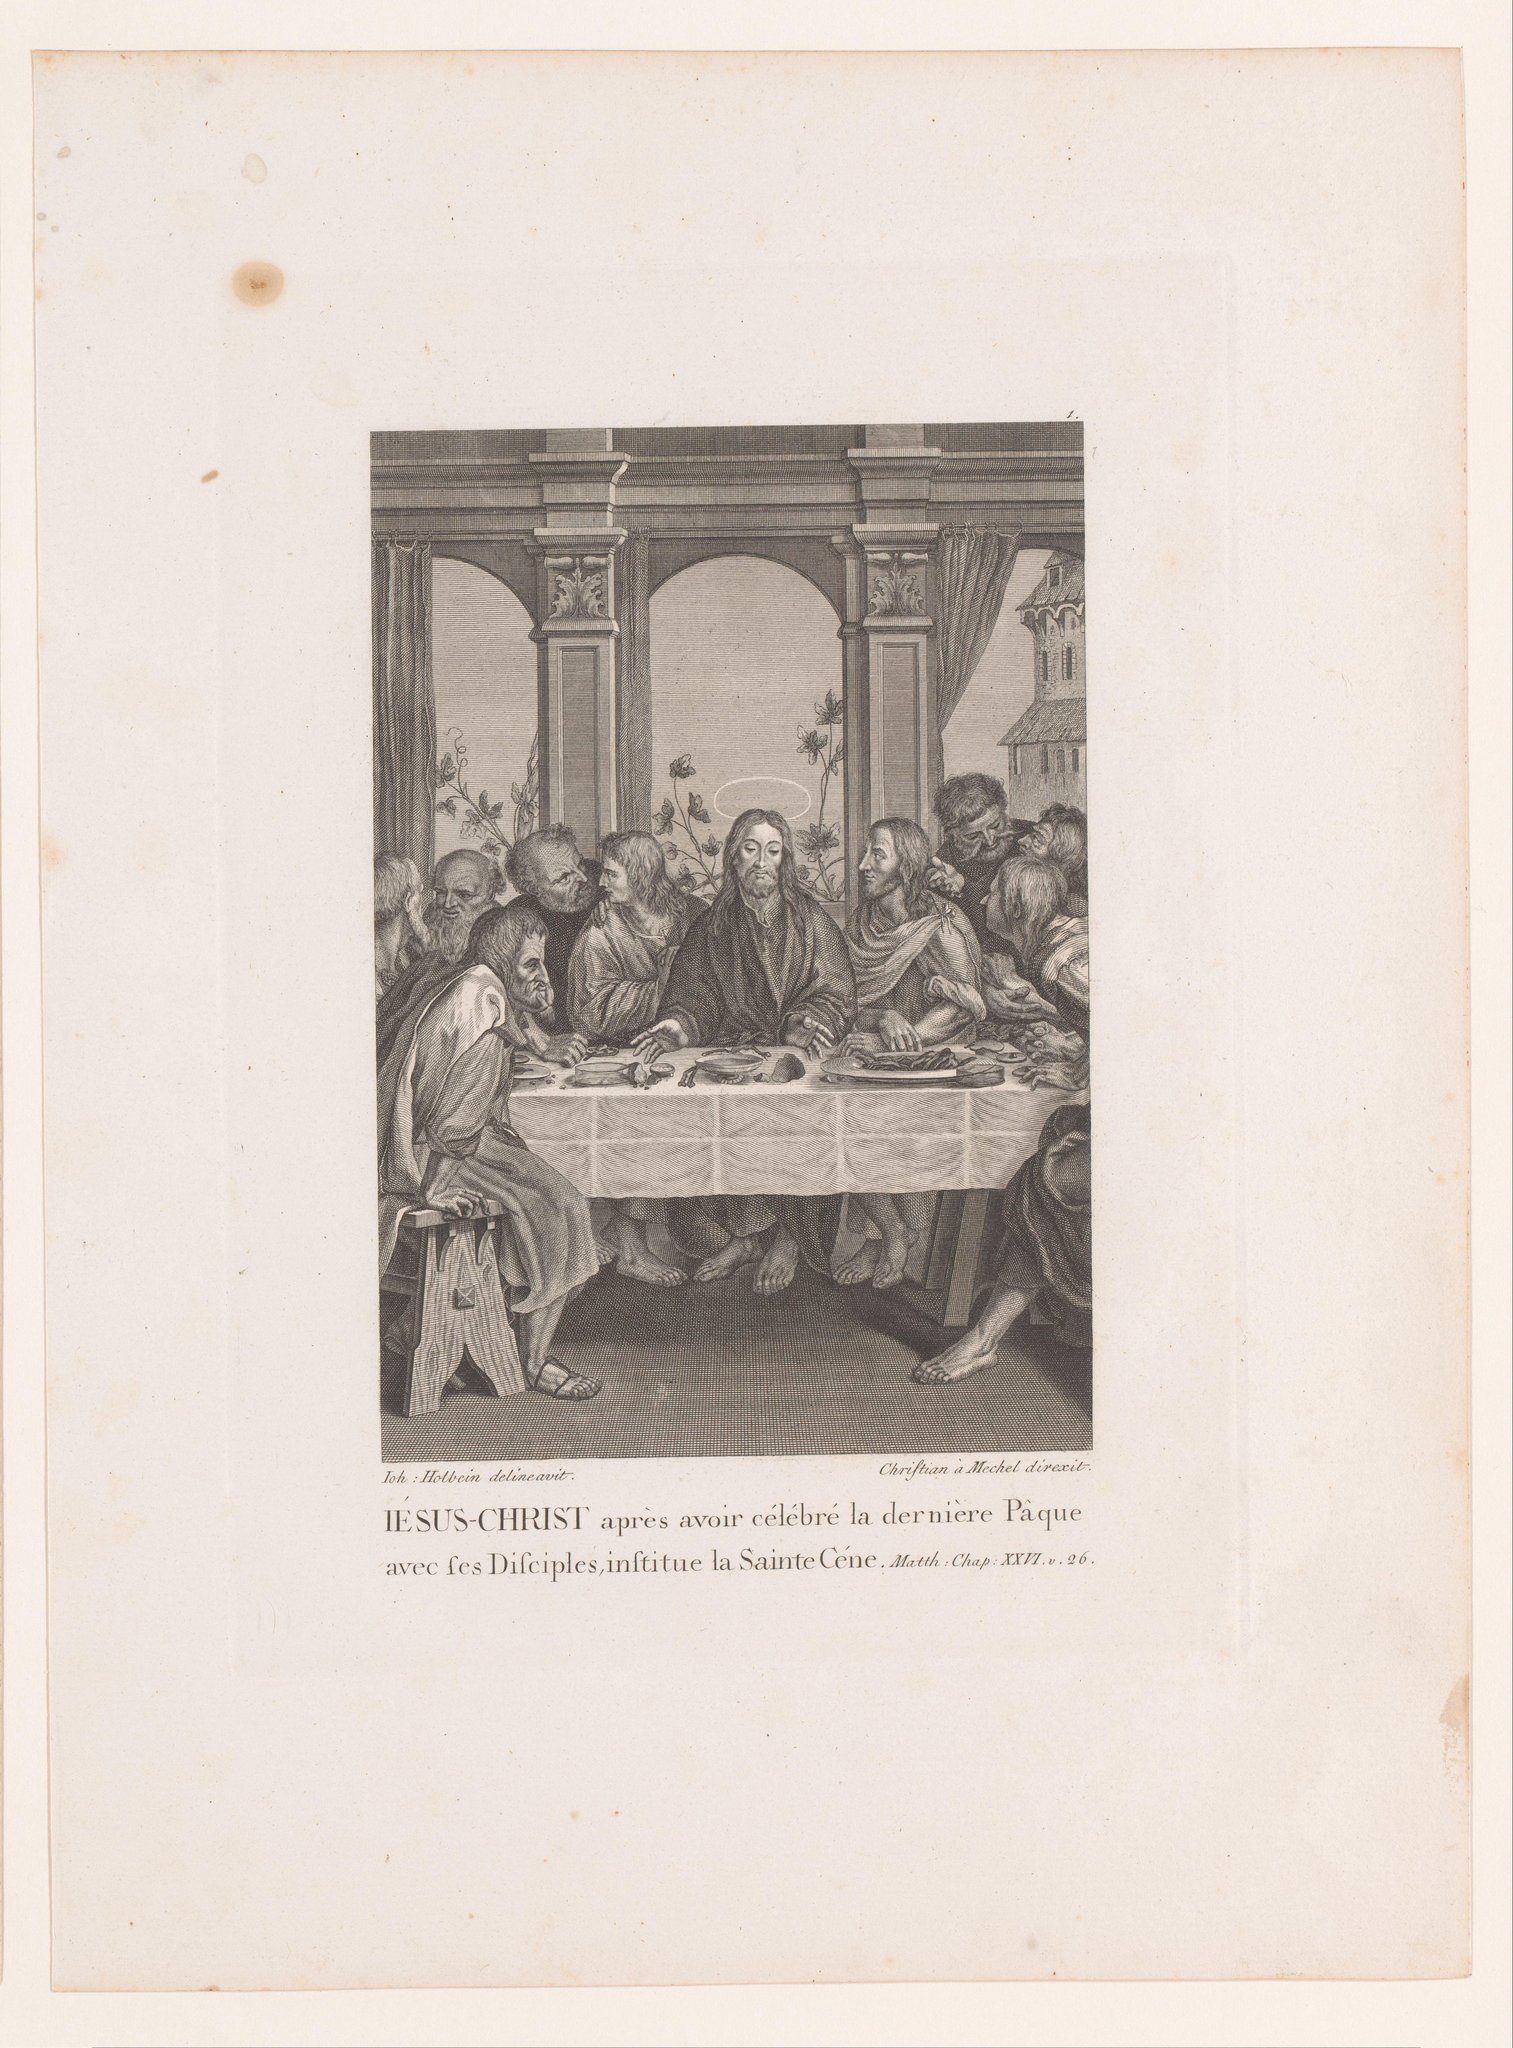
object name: print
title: Passie van Christus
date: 1784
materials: paper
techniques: etching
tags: last supper (in general) (matthew 26:21-35; mark 14:18-31; luke 22:3, 22:15-23; john 13:21-38)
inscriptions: collector's mark: Lugt 2228, collector's mark: Lugt 4404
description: De serie is deel twee van de vier-delige publicatie 'Oeuvre de Jean Holbein', Bazel 1780-1795, door Christian von Mechel.